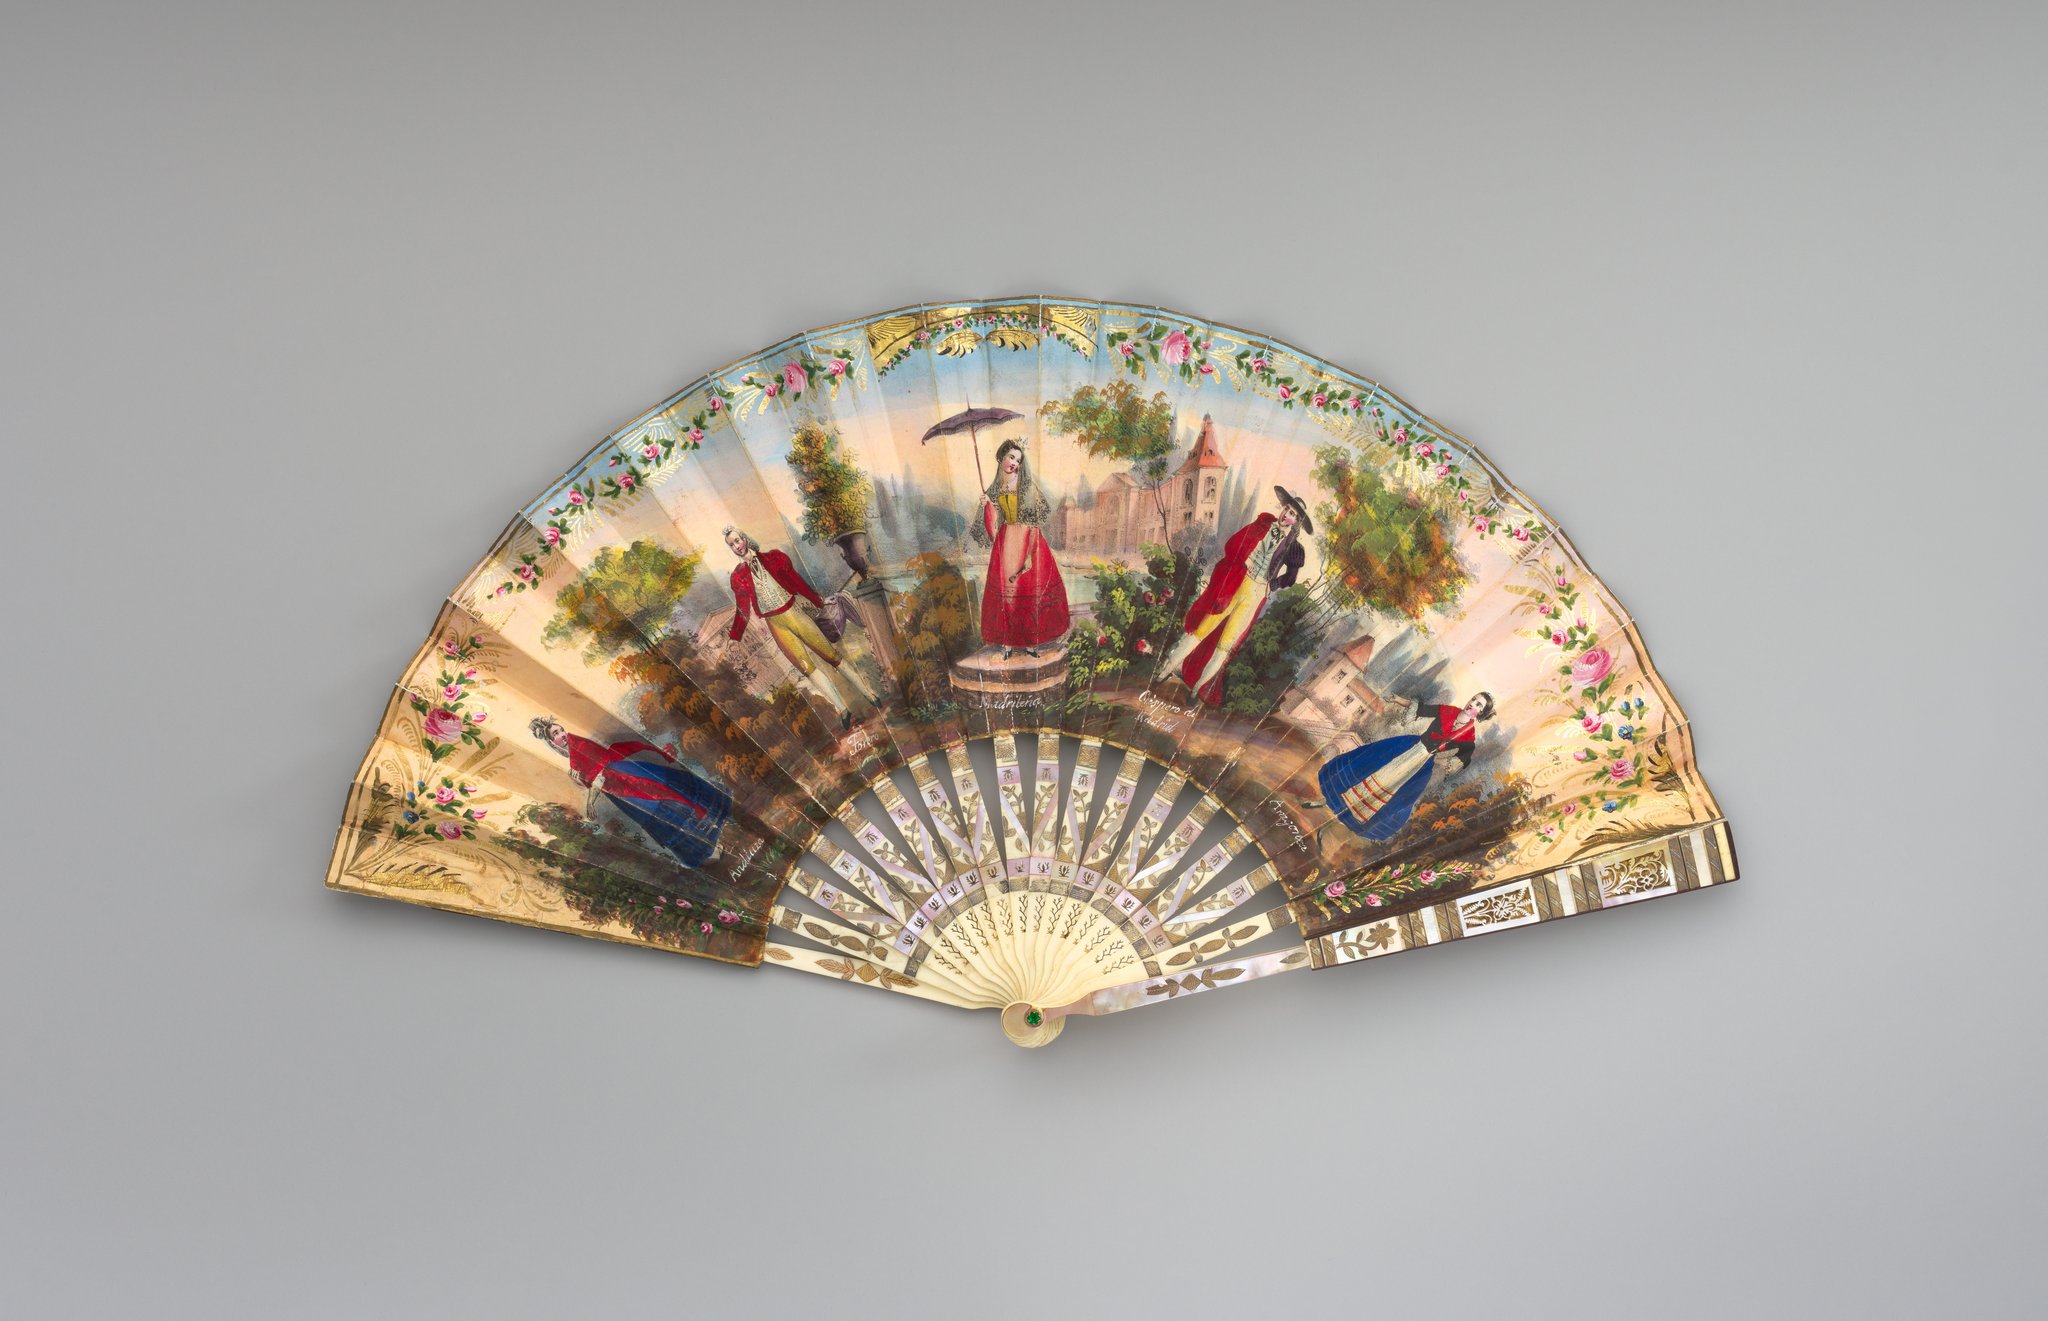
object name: fan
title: Fan depicting figures in Spanish costumes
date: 1835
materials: gilt, glass, ivory, mother of pearl, paint, paper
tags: men,women